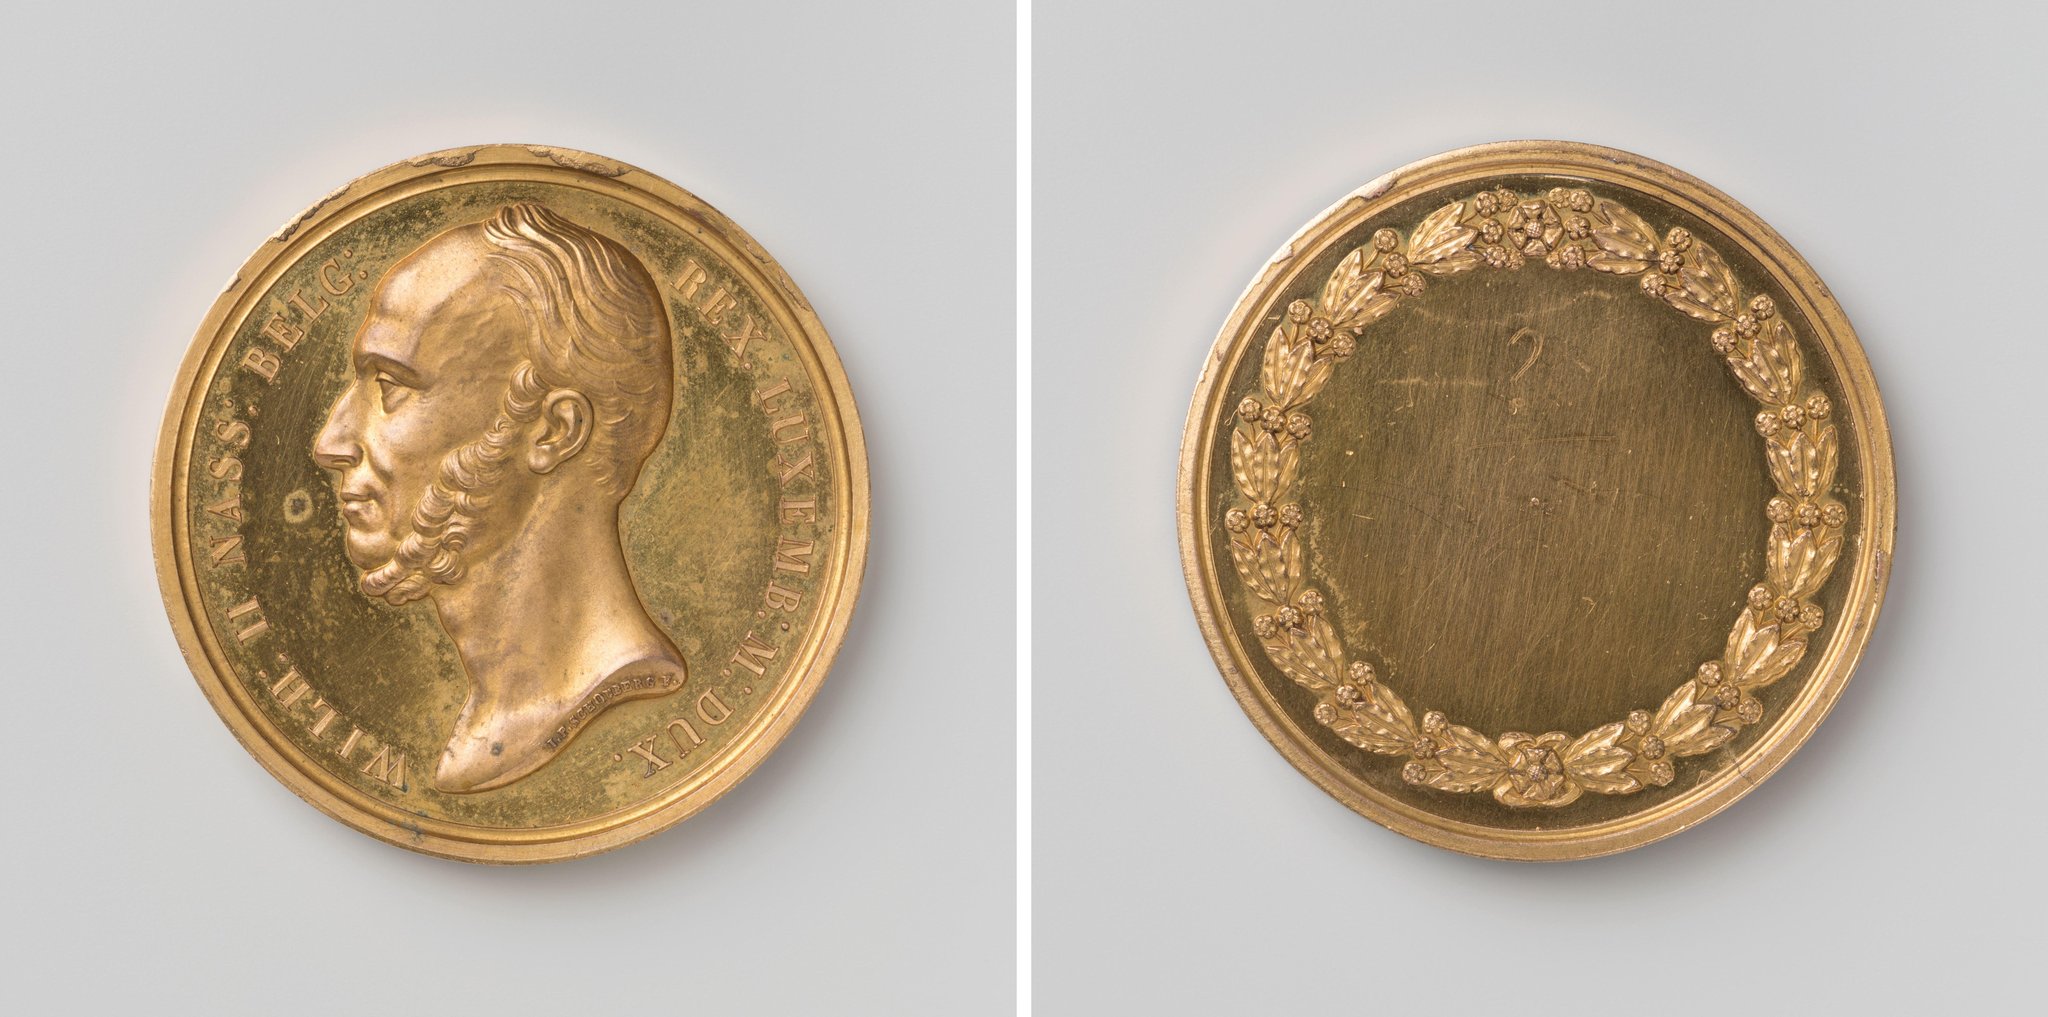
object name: medal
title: Willem II, koning der Nederlanden, penning van de eerste grootte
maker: johannis petrus schouberg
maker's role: die cutter, draughtsman, print maker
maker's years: 1798-1864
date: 1840-1841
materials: metal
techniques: gilding, striking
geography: utrecht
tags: william ii of the netherlands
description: Voorzijde: borststuk man binnen omschrift. Keerzijde: blanco veld binnen krans van myrtebladeren